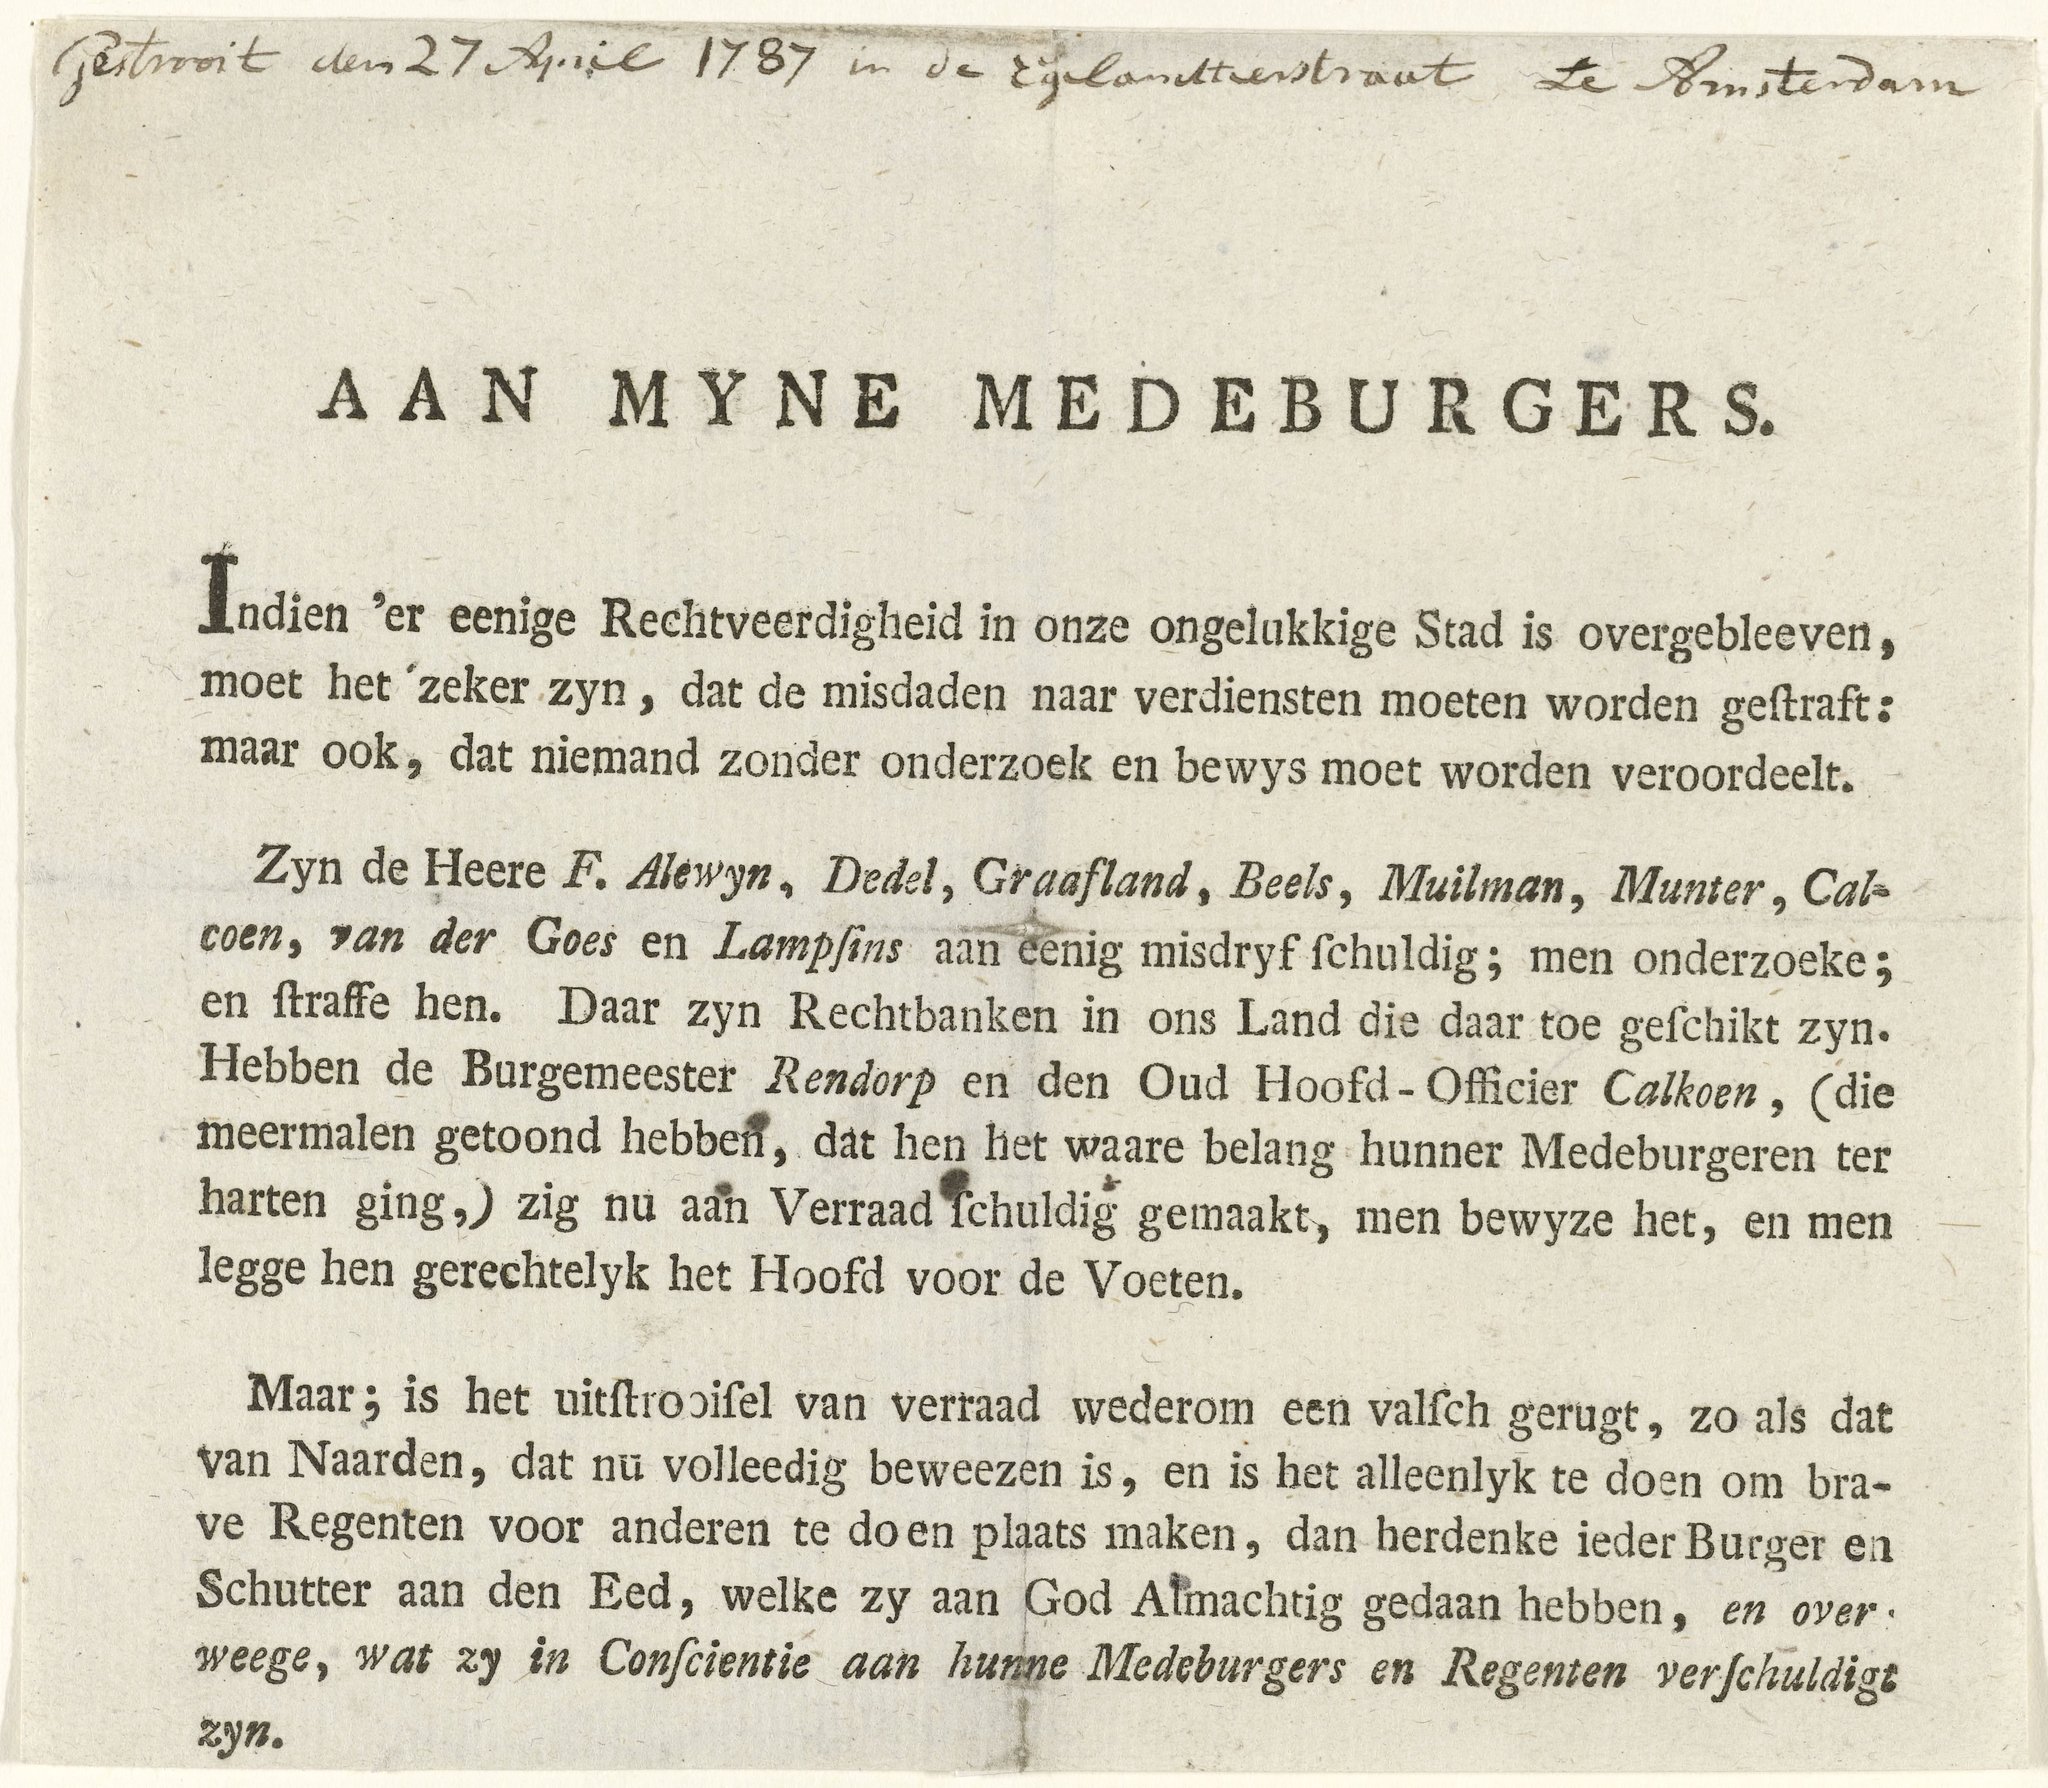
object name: text sheet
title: Aan myne medeburgers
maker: Anonymous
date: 1787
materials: paper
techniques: letterpress printing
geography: amsterdam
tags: amsterdam, patriots (1780-1795)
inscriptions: inscription: ‘Getrooit den 27 April 1787 in de Eglandtierstraat te Amsterdam’, collector's mark: Lugt 2228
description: Strooibiljet met een verdediging door de negen op 21 april 1787 afgezette Amsterdamse raadsleden.